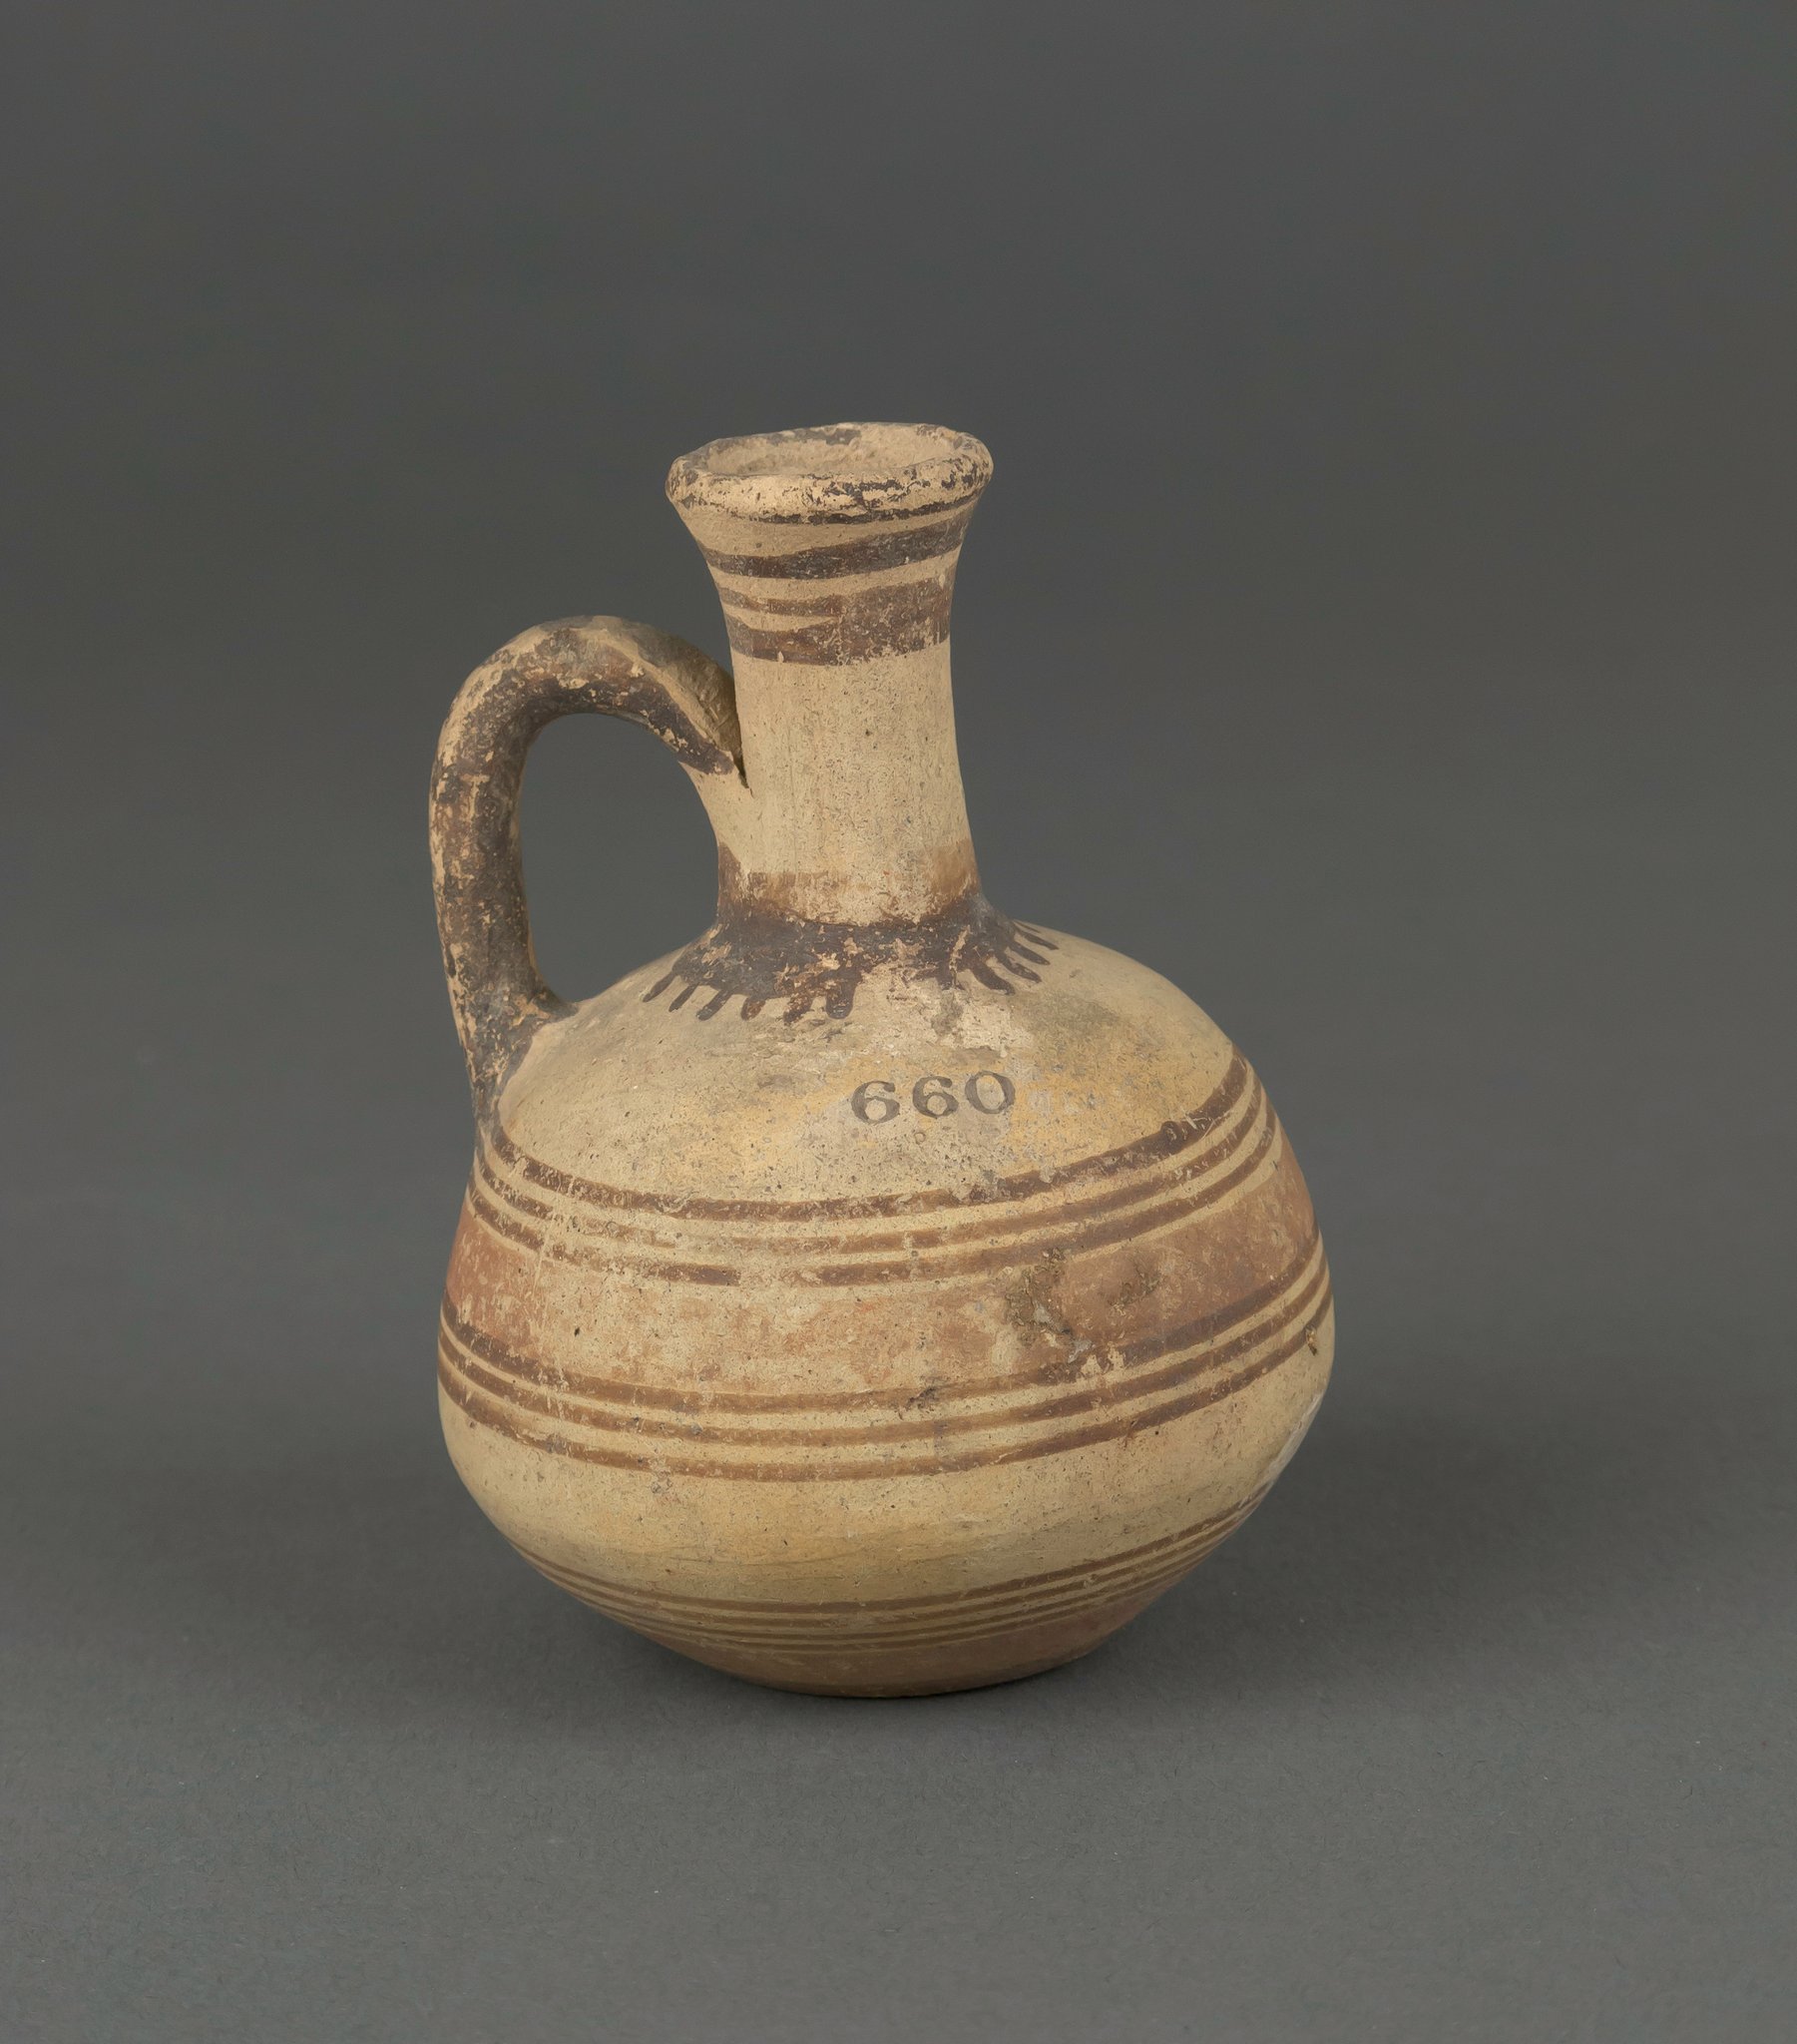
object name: juglet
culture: cypriot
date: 750-480 BCE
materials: terracotta